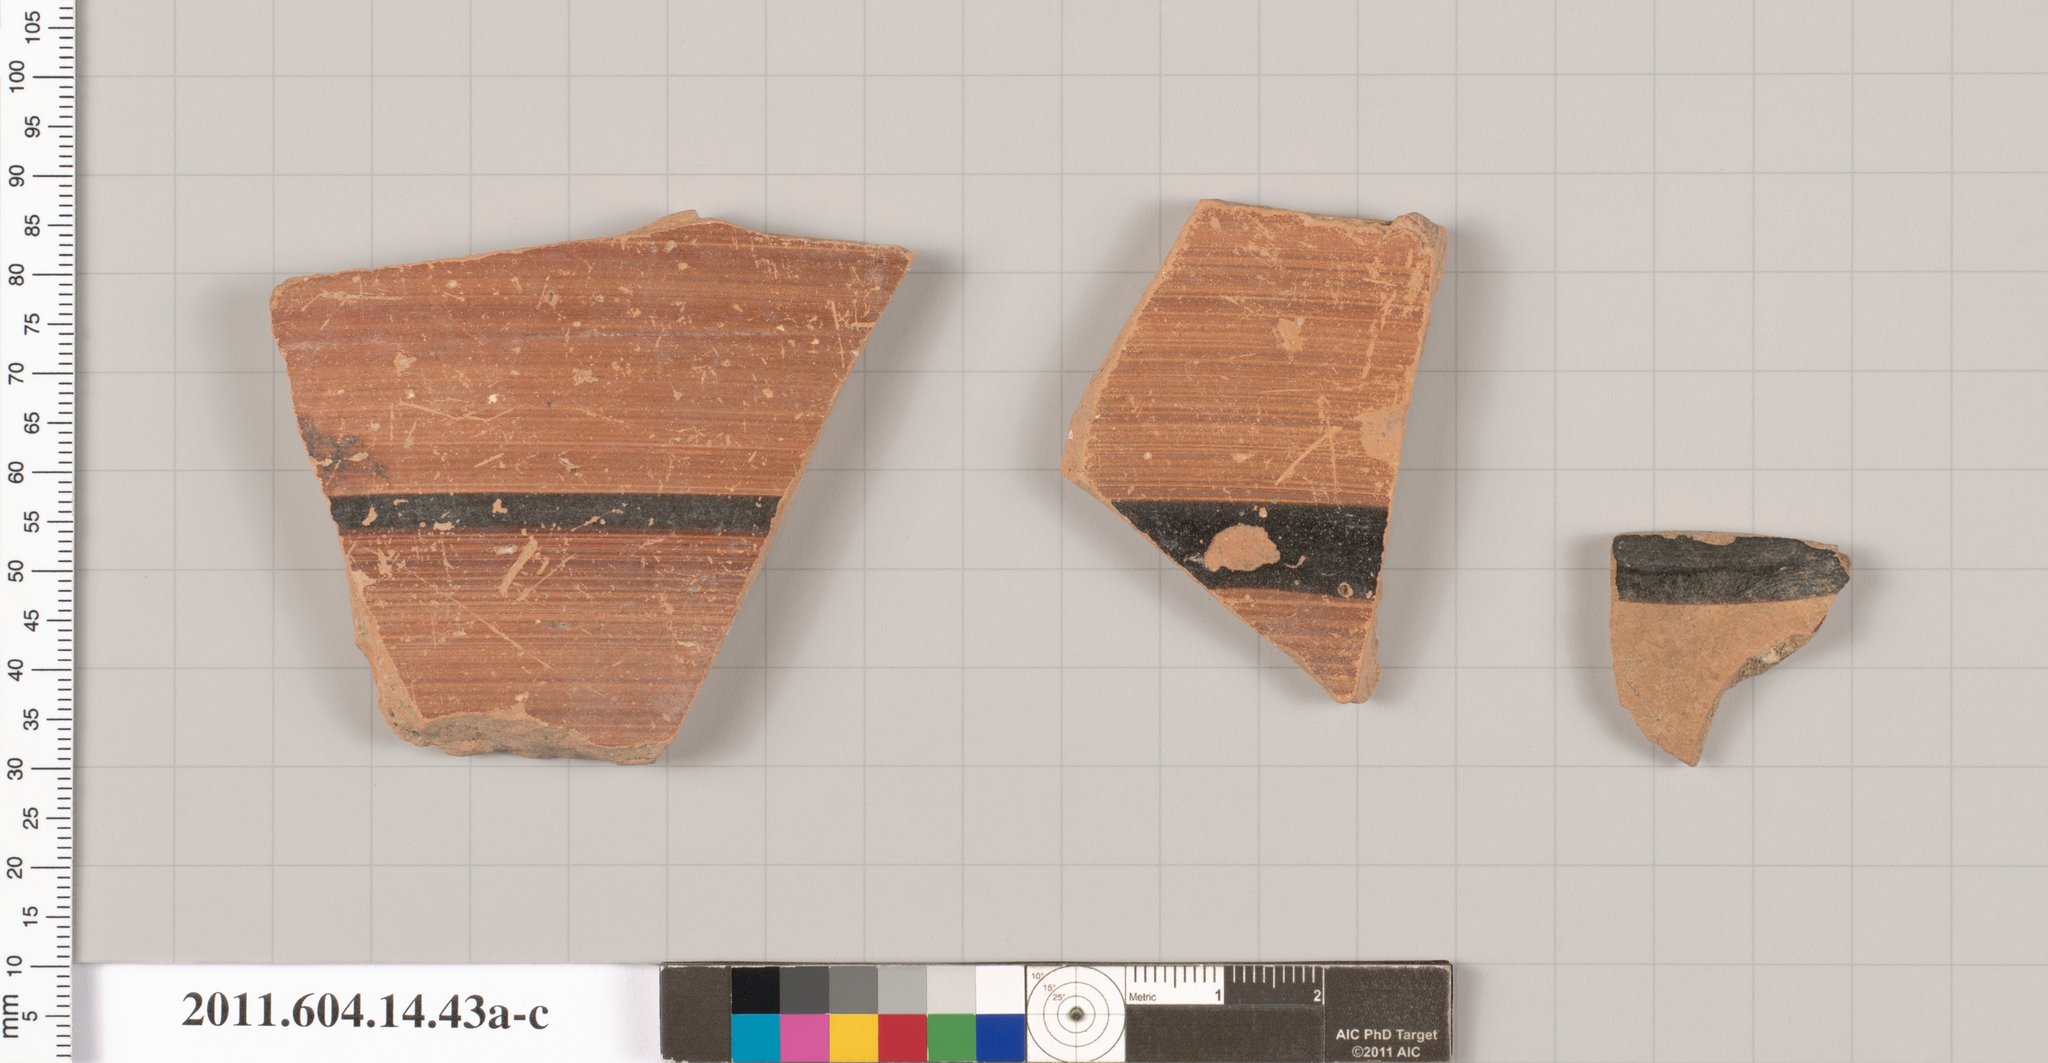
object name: undetermined open shape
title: Terracotta fragments of open shapes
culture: unknown fabric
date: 600-401 BCE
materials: terracotta